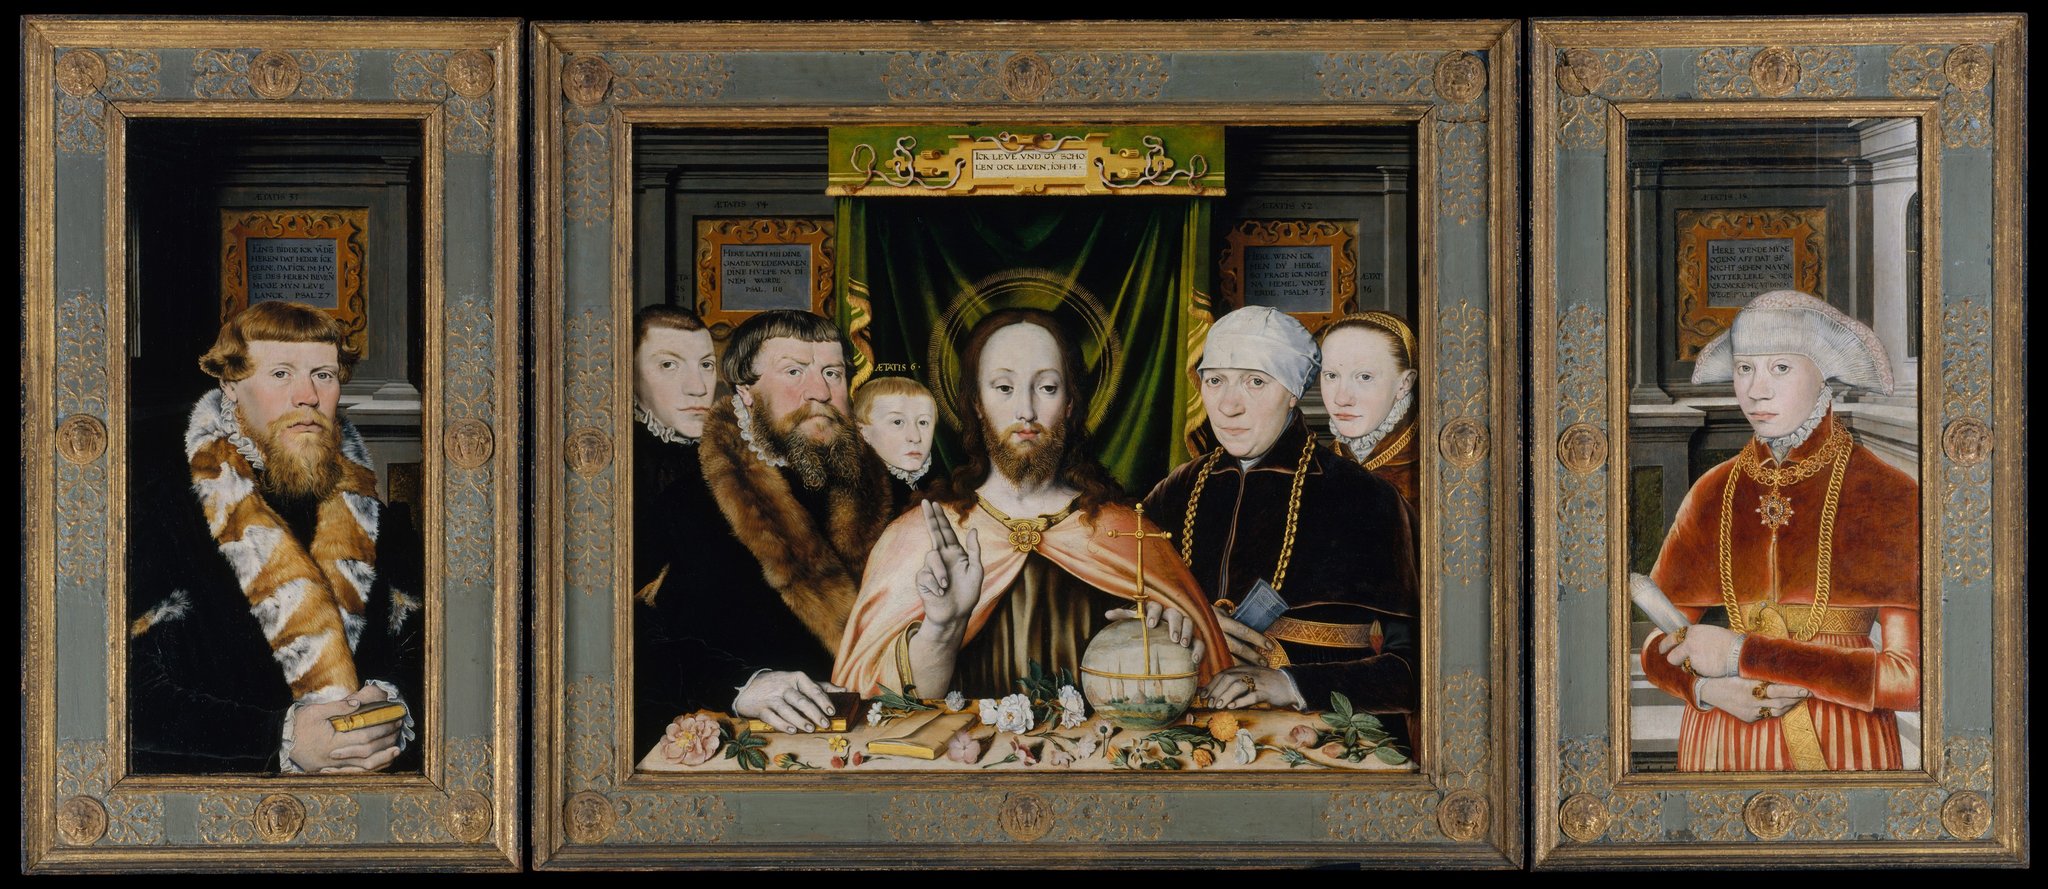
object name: painting, triptych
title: Christ Blessing, Surrounded by a Donor Family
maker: german painter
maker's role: artist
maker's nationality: german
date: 1573-1582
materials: gold, wood, oil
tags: men,women,christ